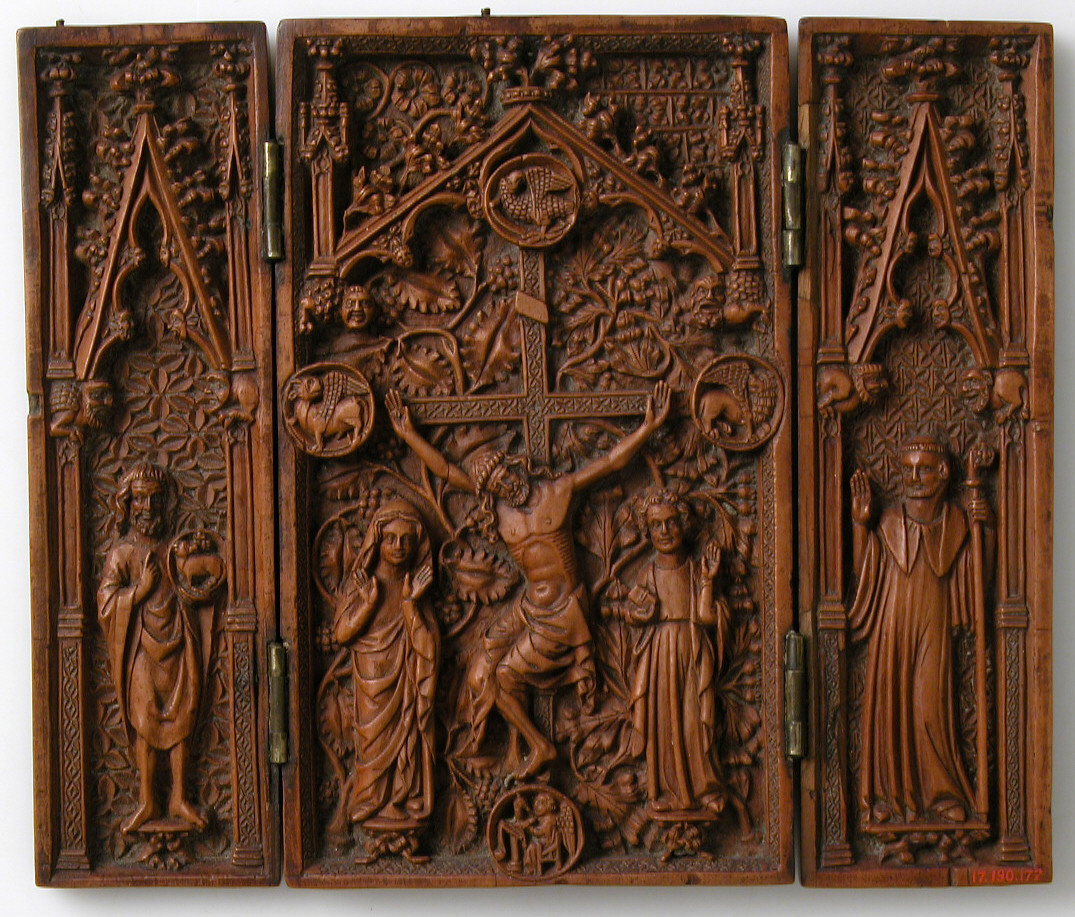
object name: triptych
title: Crucifixion Triptych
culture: german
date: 1401-1500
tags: christ,saint john the baptist,virgin mary,crucifixion,evangelists